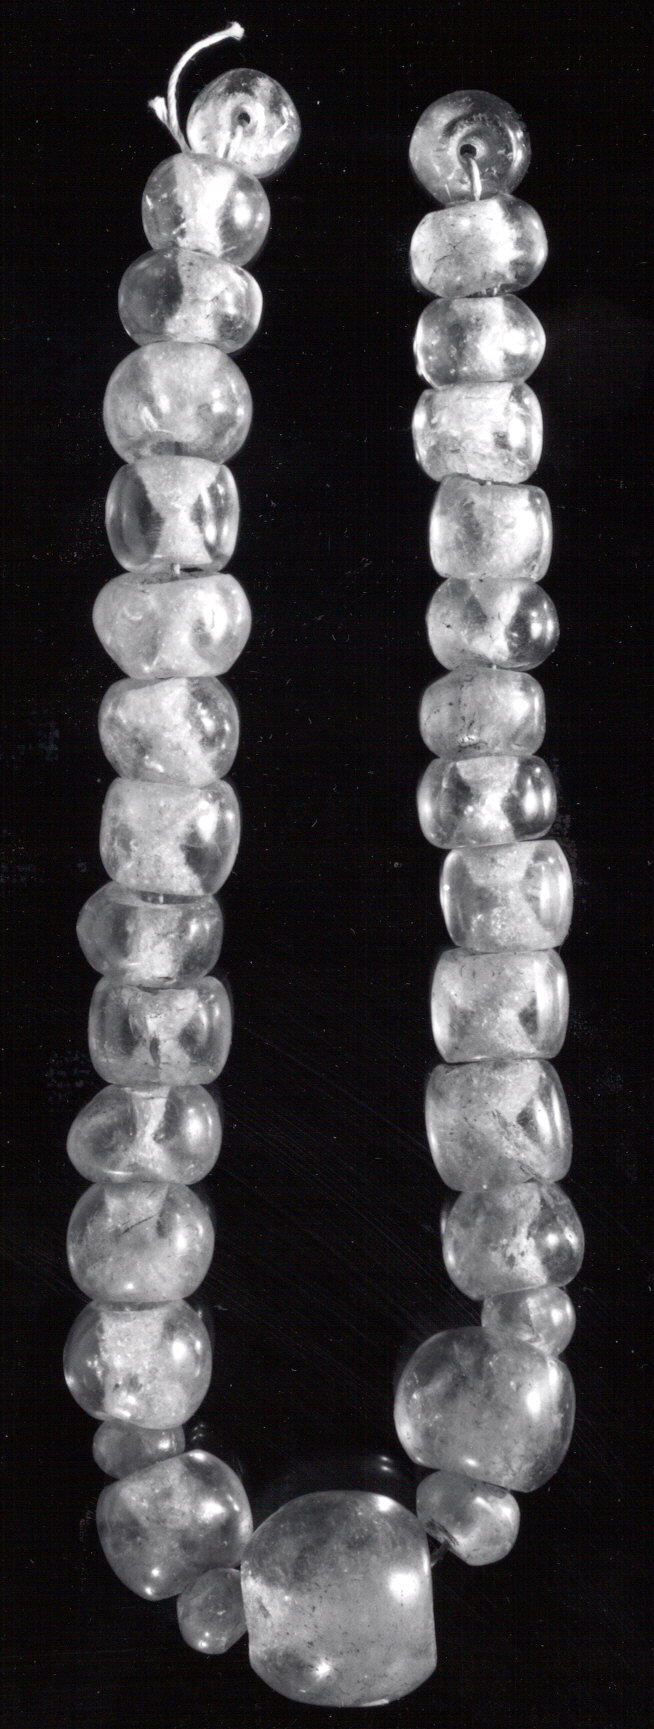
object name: necklace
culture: moche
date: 201-600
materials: gemstone, quartz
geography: peru